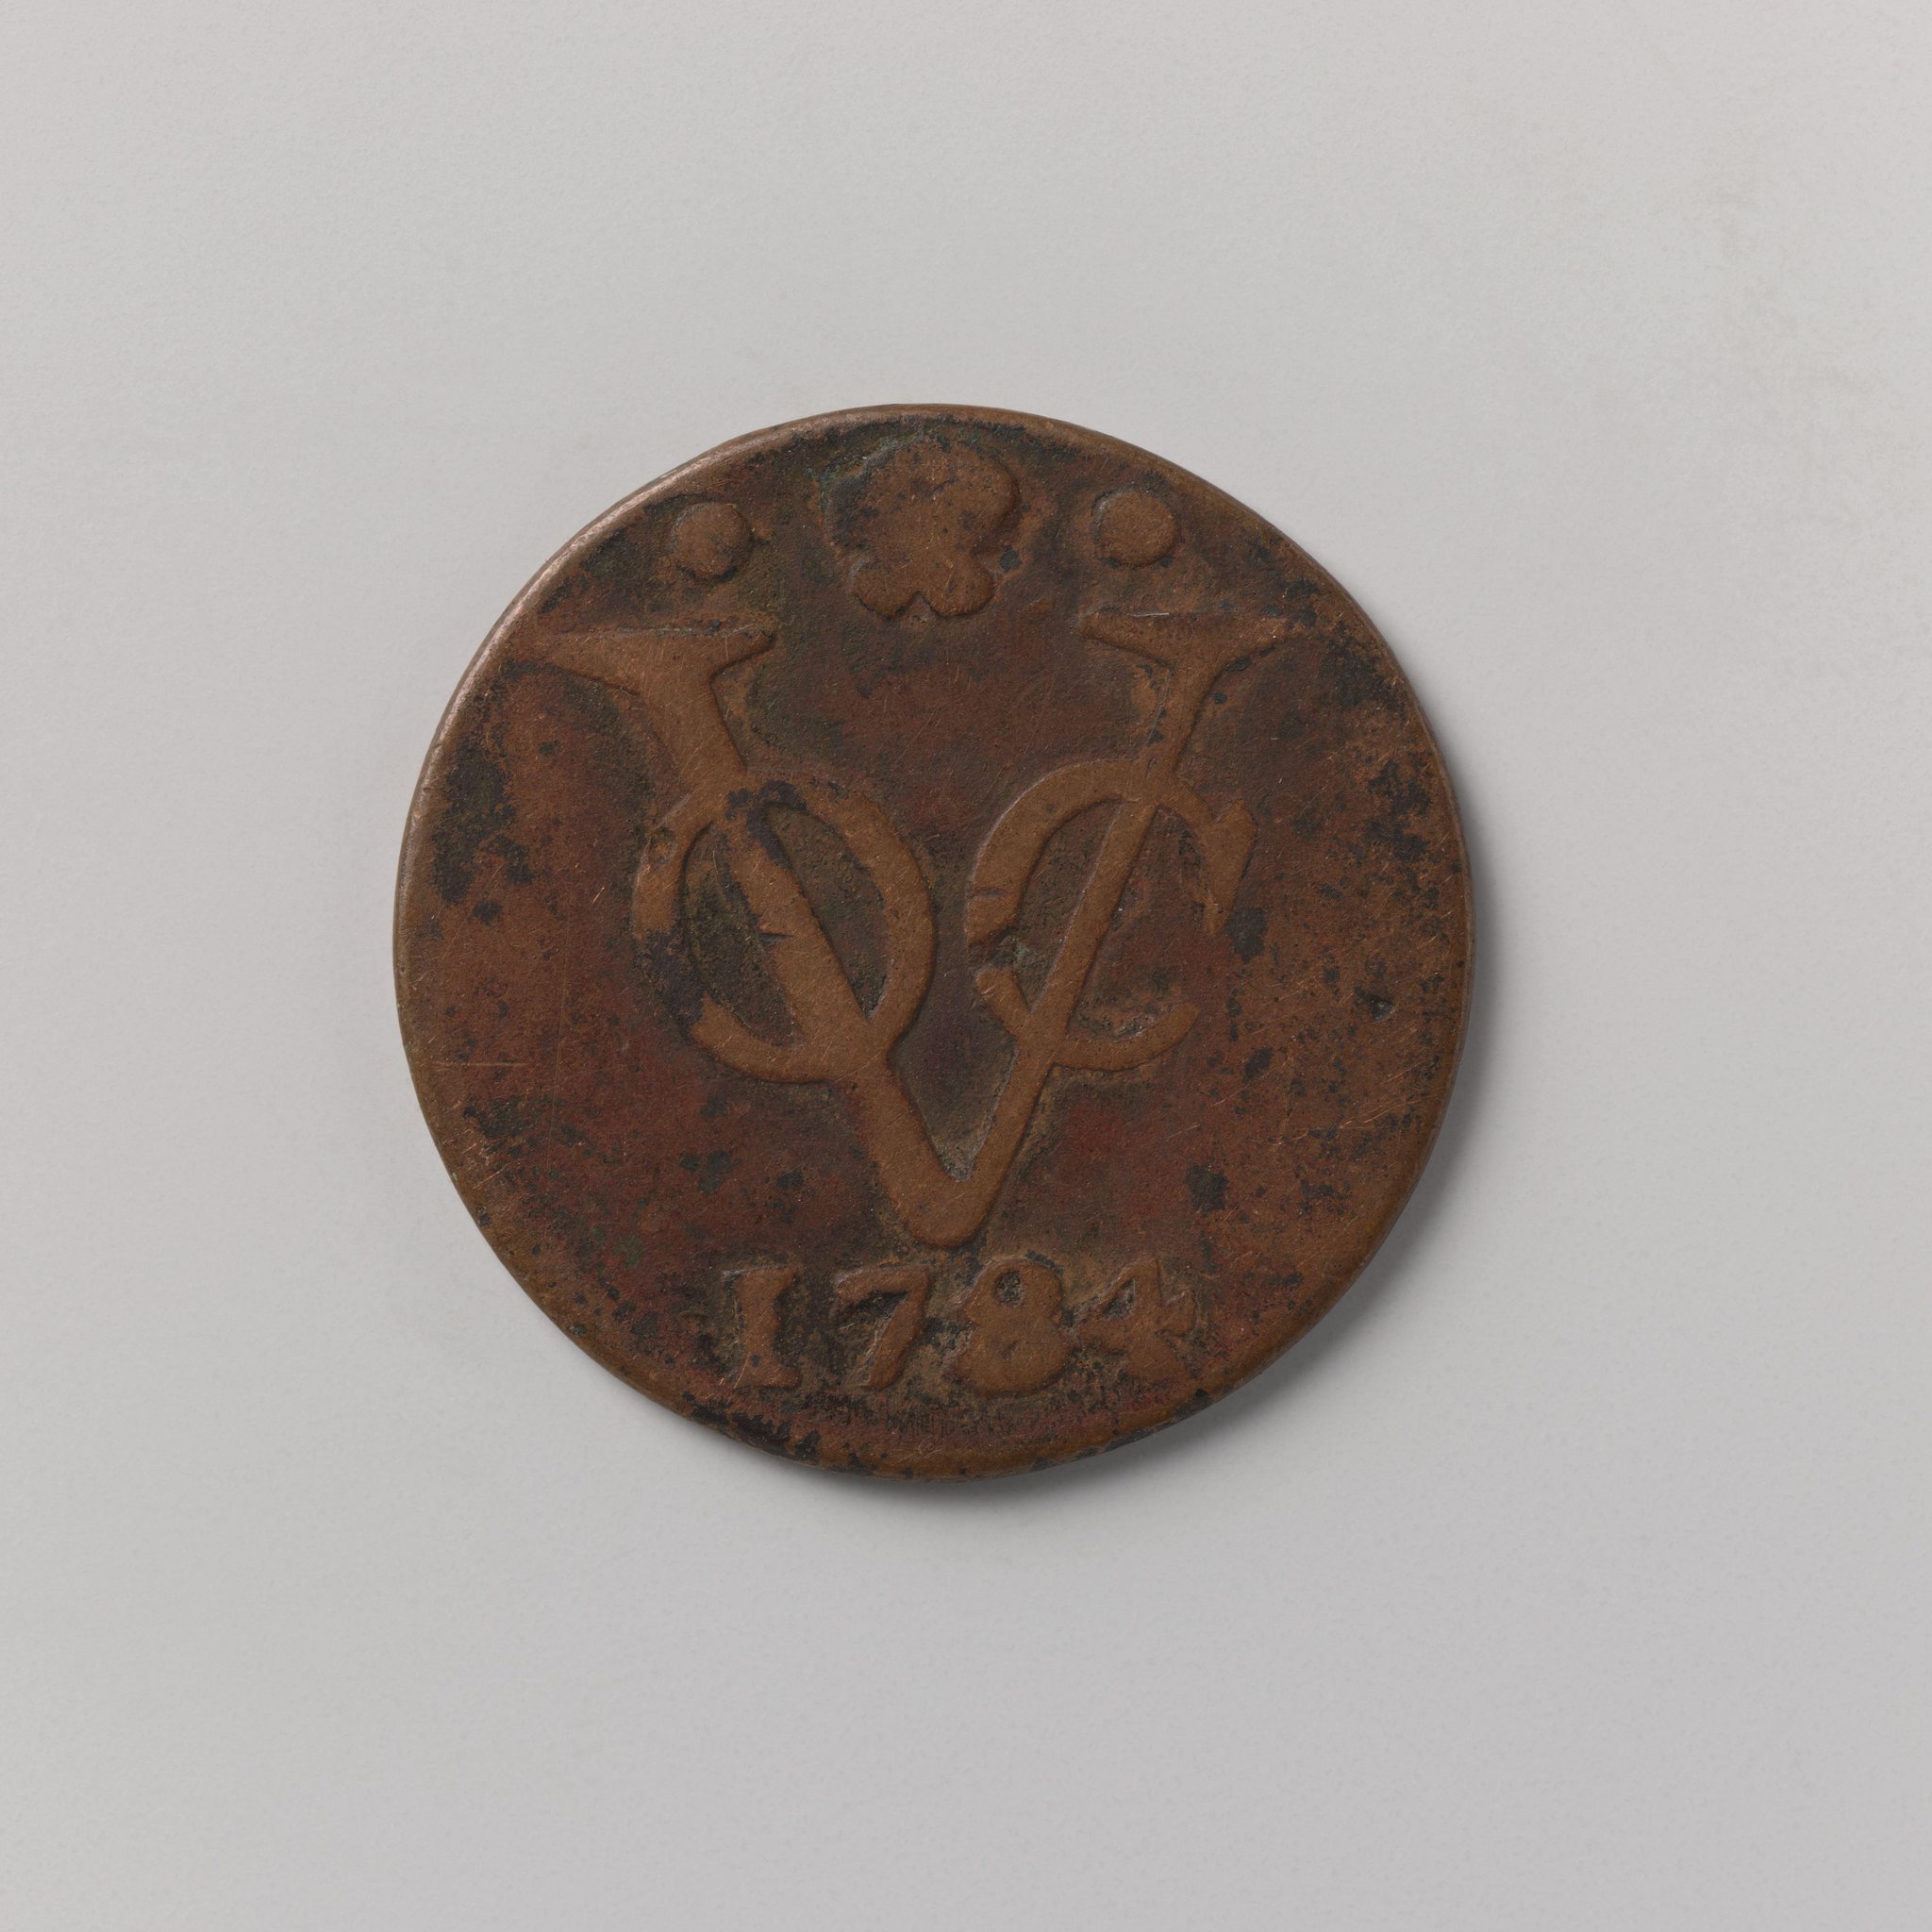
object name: coin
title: Duit van de VOC uit Holland, 1784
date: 1784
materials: copper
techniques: striking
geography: dordrecht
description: Koperen munt. Voorzijde: gekroond wapenschild van Holland. Keerzijde: monogram van de VOC, waarboven muntteken en waaronder jaartal. Gladde rand.